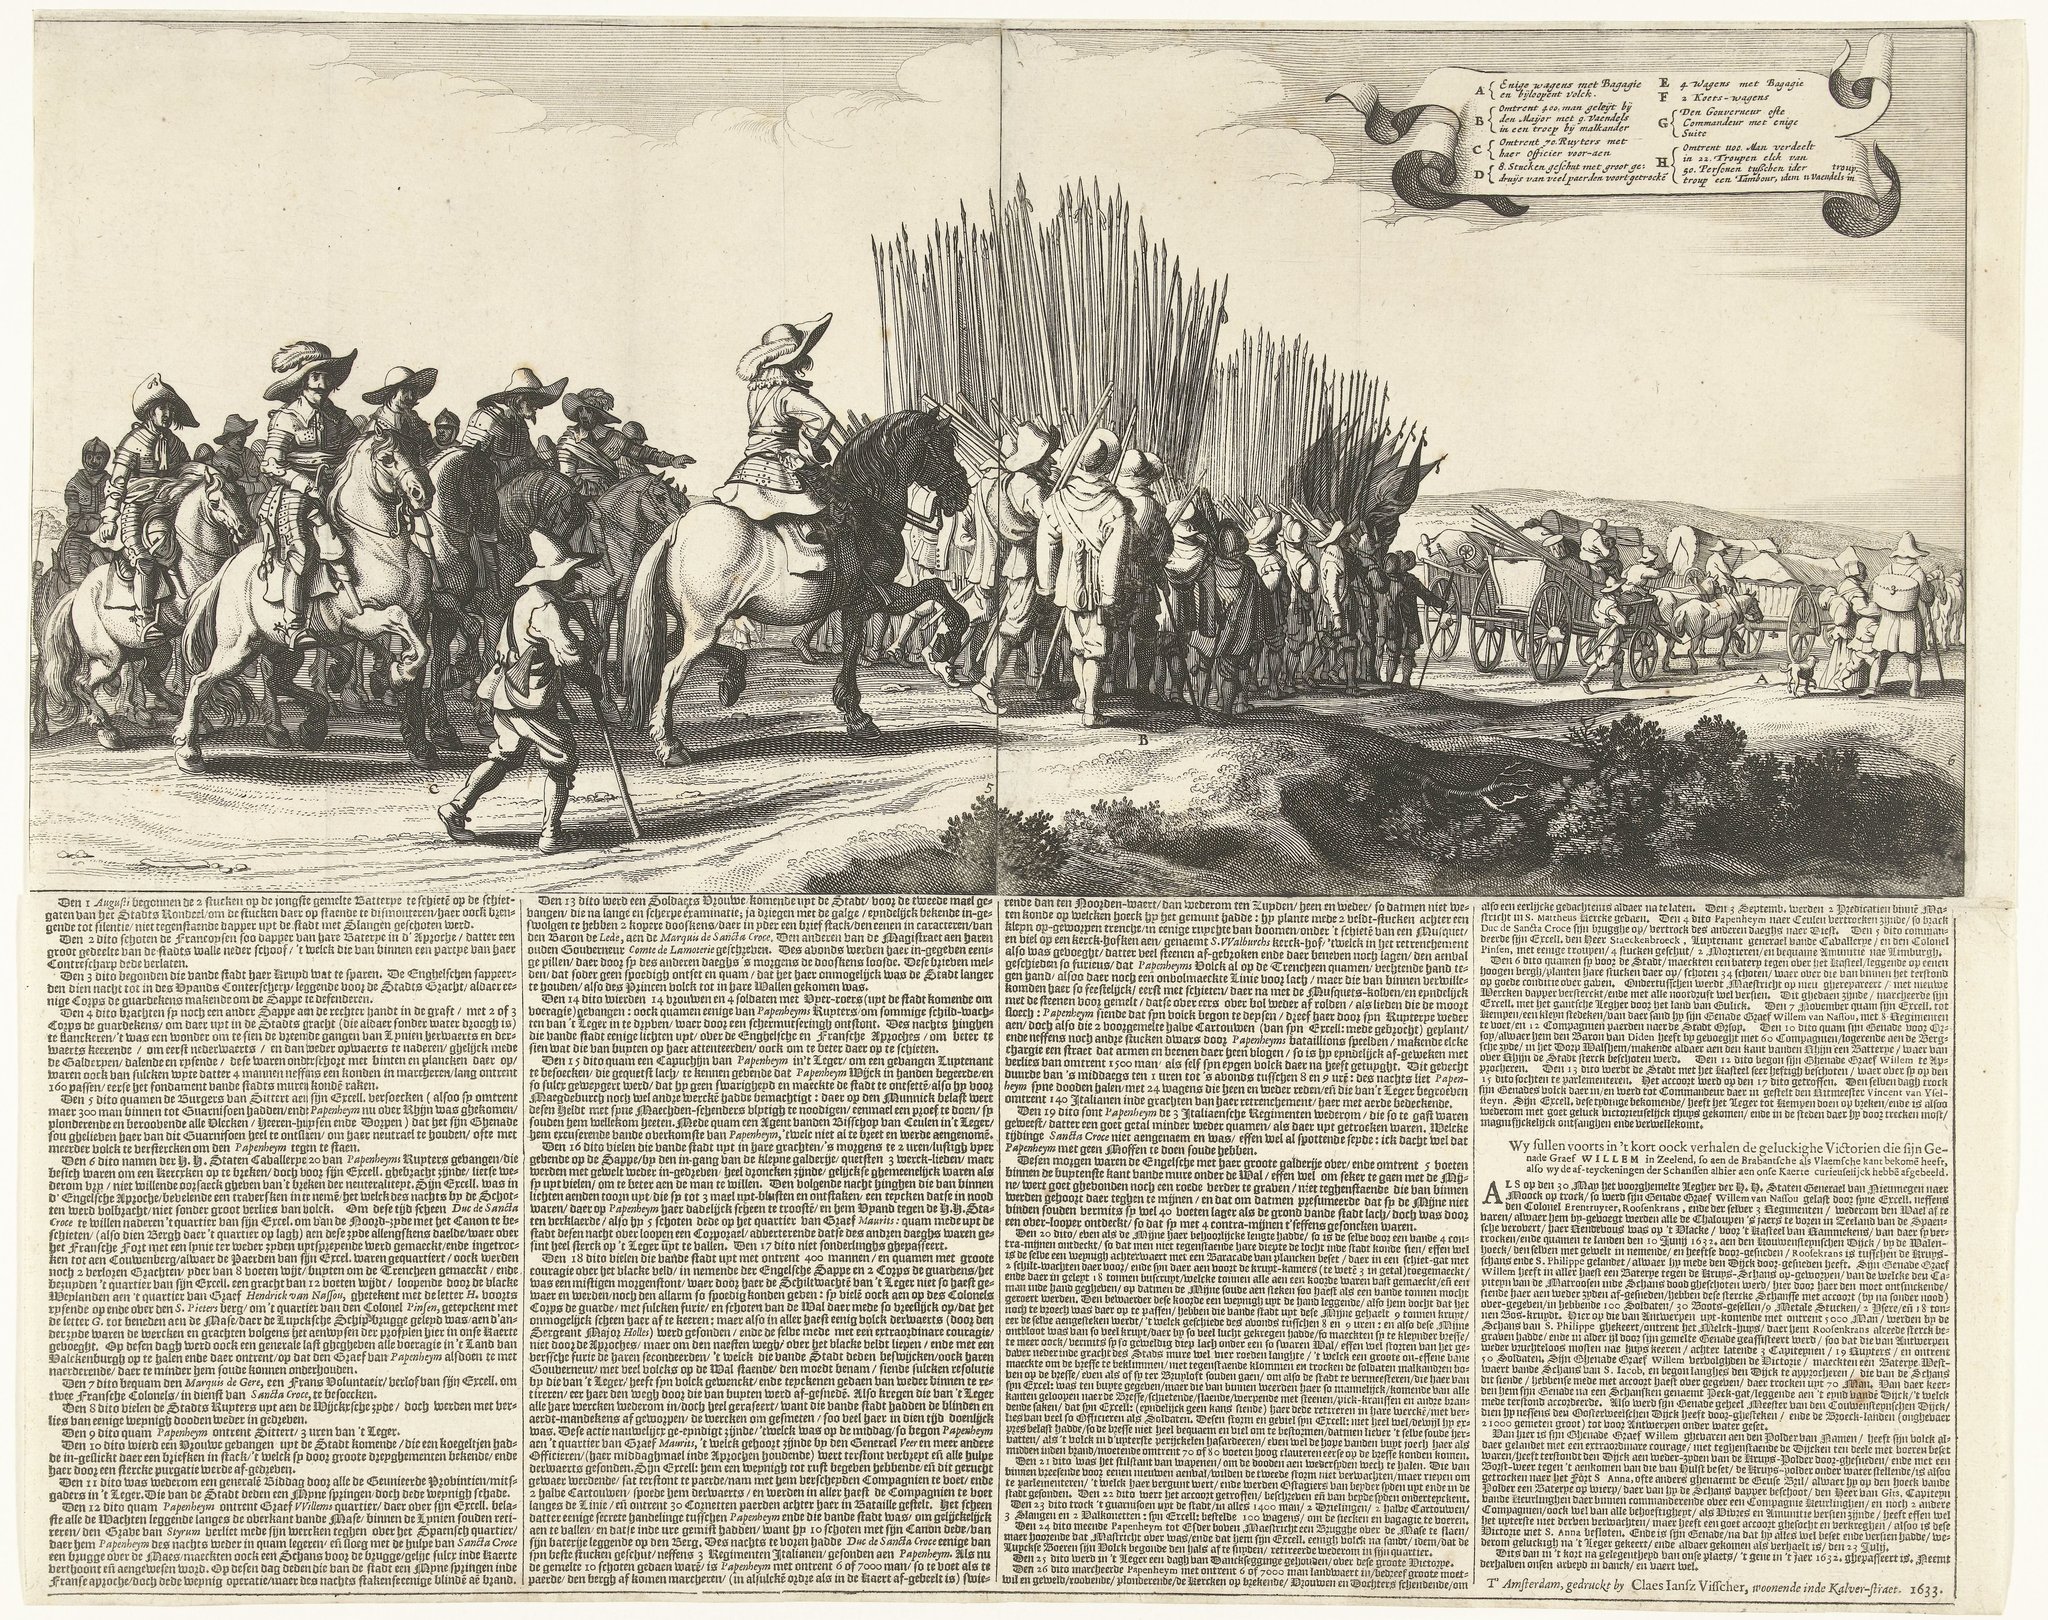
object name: print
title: Uittocht van het Spaanse leger uit Maastricht, 1632 (platen 5 en 6)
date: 1633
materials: paper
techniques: etching, letterpress printing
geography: amsterdam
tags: delft, frederick henry (prince of orange), retreat of the defeated, maastricht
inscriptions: date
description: Uittocht van het Spaanse leger uit Maastricht, 23 augustus 1632. Fries van zes genummerd platen, platen nrs. 5 en 6 aan elkaar geplakt. Cavalerie, infanterie en wagens in de stoet van vertrekkende soldaten. In de lucht een cartouche met de legenda A-H. Onder elk van de platen tekst in twee kolommen in het Nederlands.